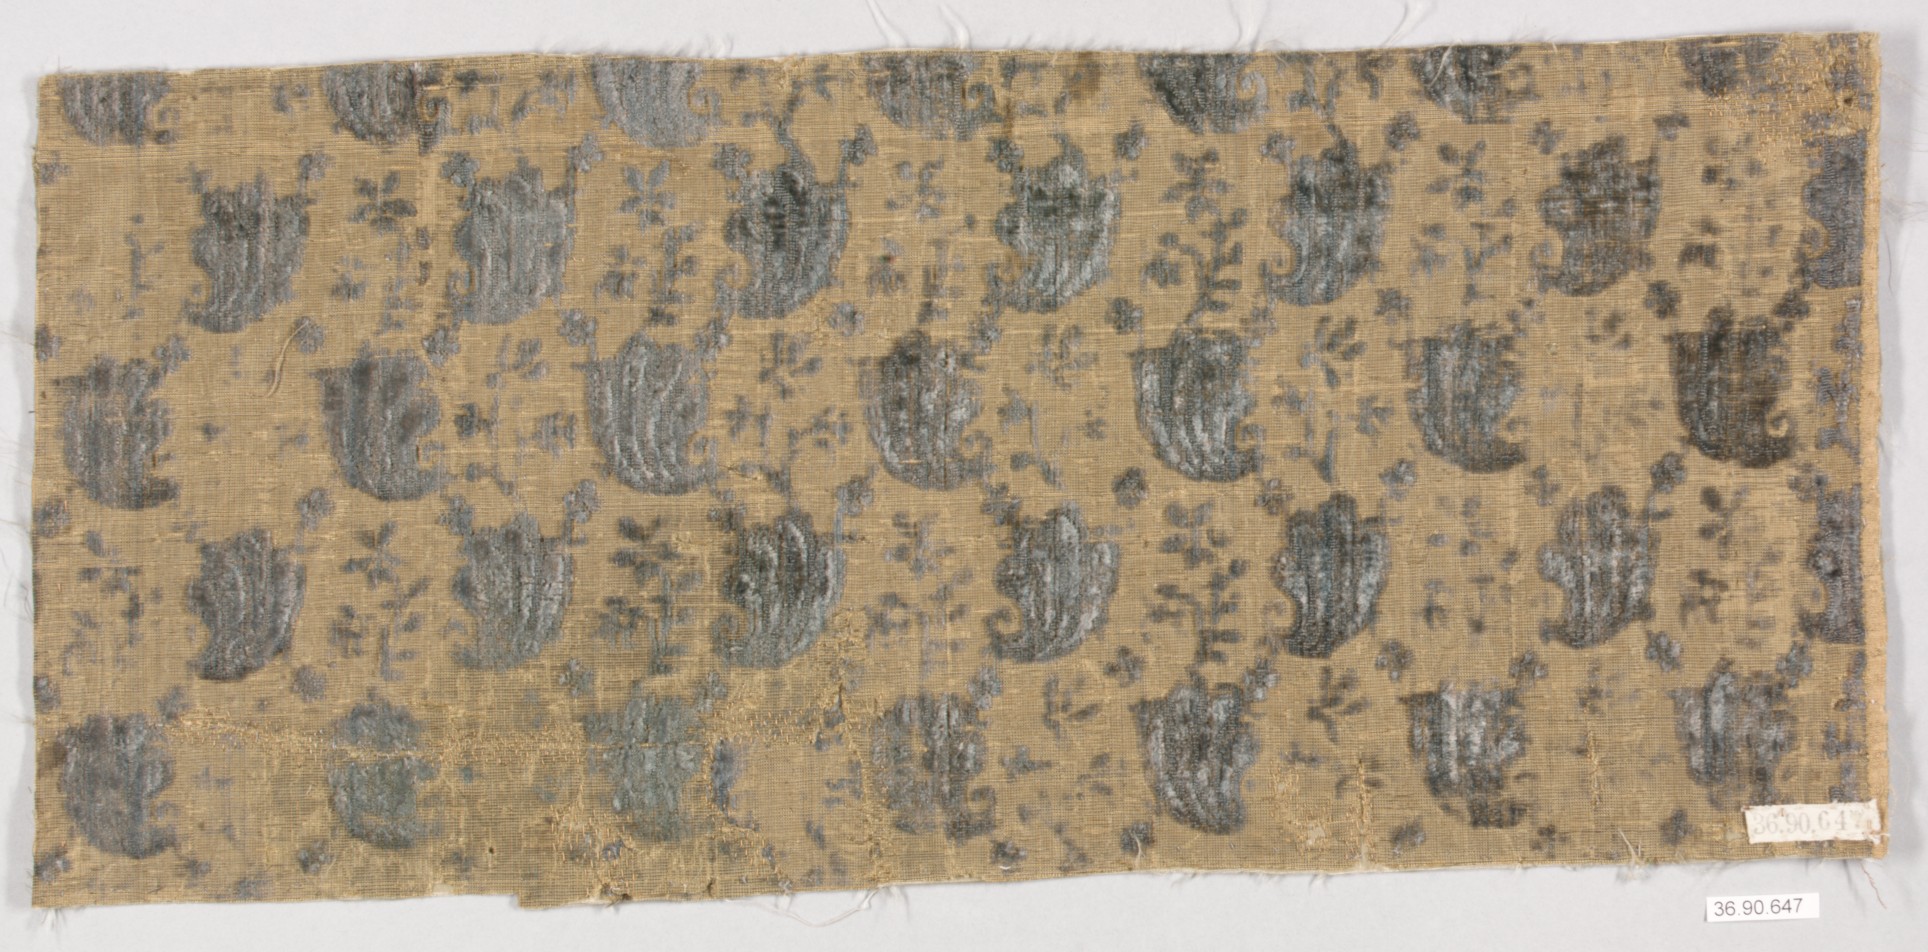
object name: piece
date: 1501-1700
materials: metal thread, silk